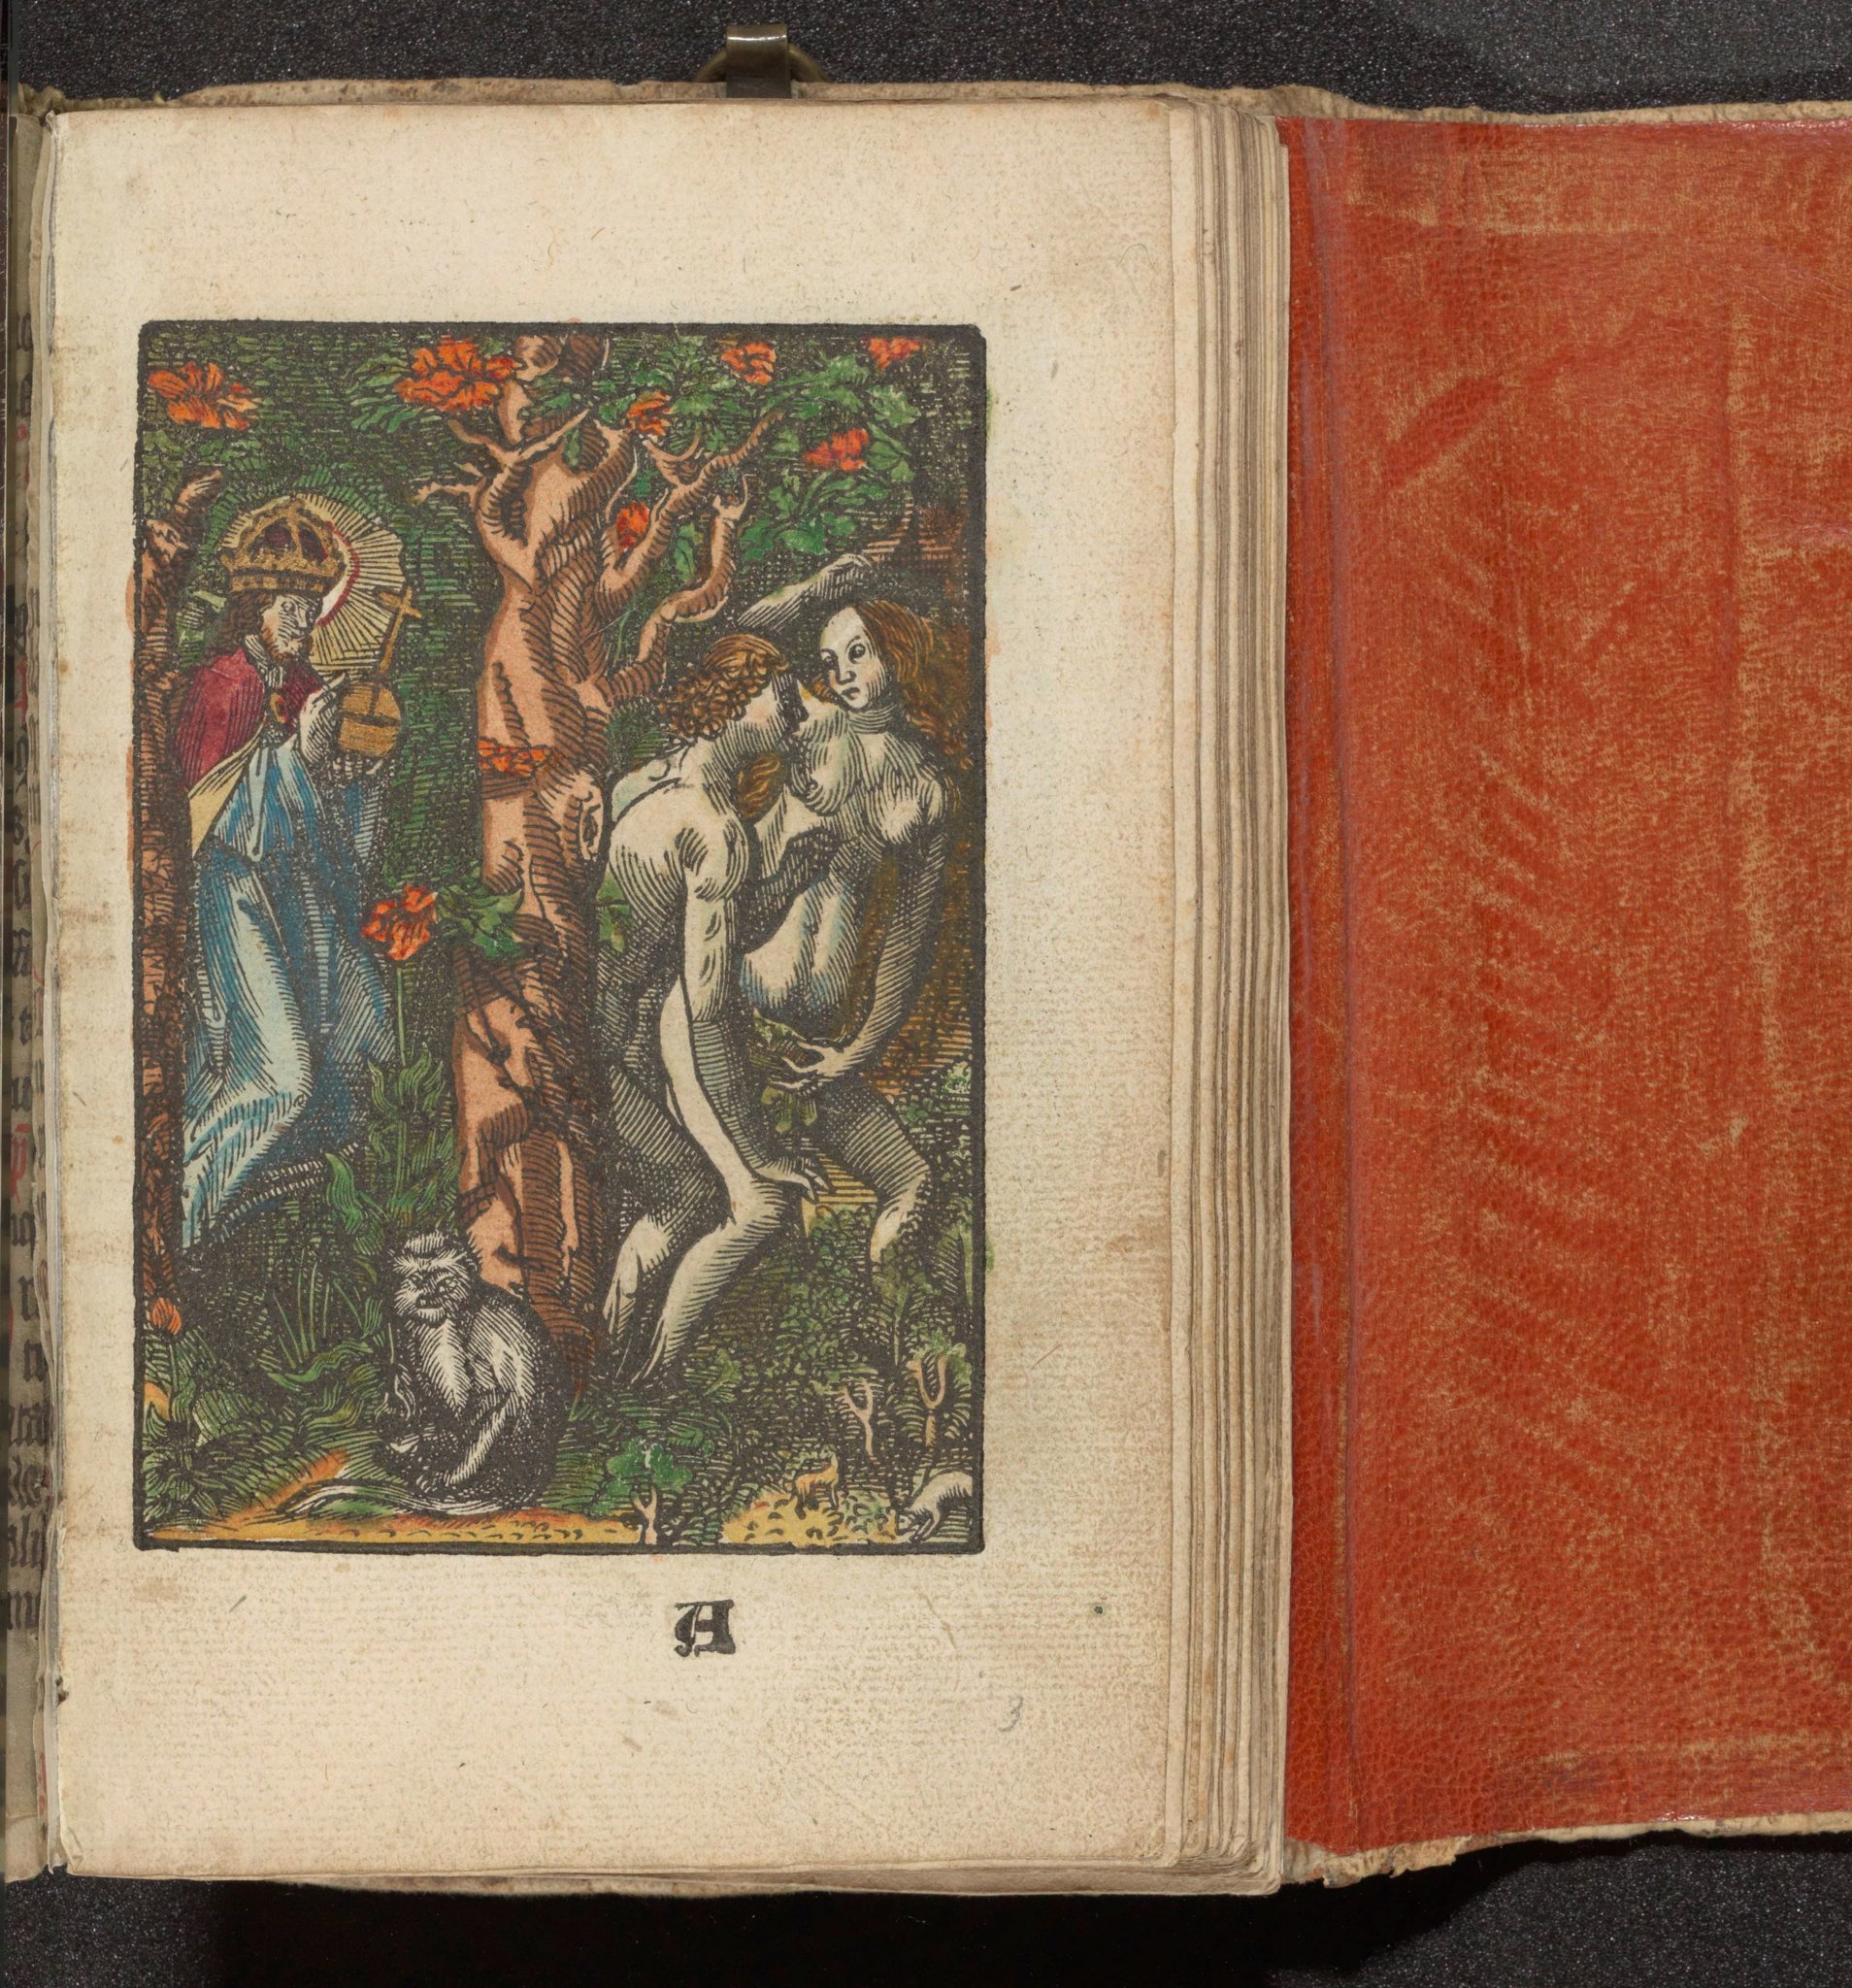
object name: book illustration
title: Stomme Passie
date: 1520-1521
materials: paper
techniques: hand coloring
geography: amsterdam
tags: book in which illustrations are essential, adam and eve hide from god, god calls adam and eve to account for their deed, adam and eve discover their nakedness; they cover themselves with their hands or with leaves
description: God wandelt door de hof van Eden en roept Adam en Eva ter verantwoording nadat zij van de boom van de kennis van goed en kwaad hebben gegeten. Adam en Eva verstoppen zich en bedekken zich met bladeren. Op de voorgrond een aap. Onder rechts van het midden gemerkt: A. Prent maakt deel uit van een boek.